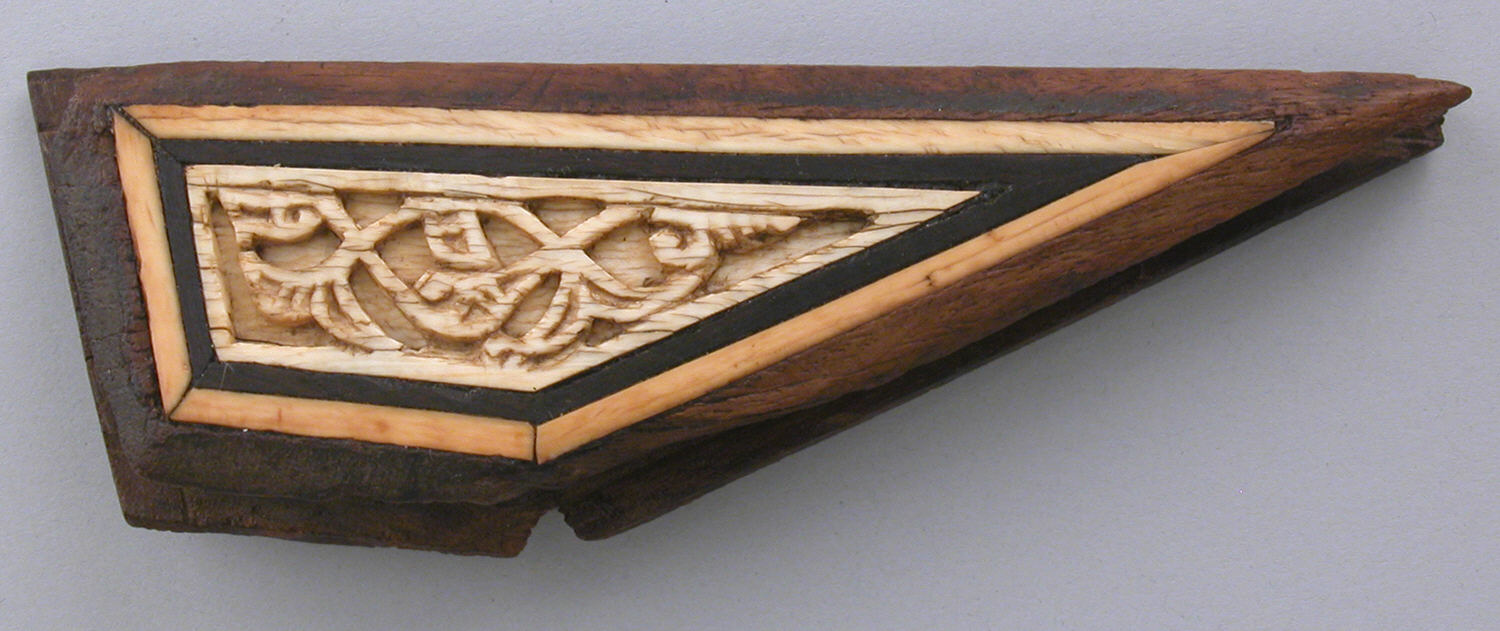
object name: panel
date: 1201-1400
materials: ivory, wood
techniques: carving, inlay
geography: egypt